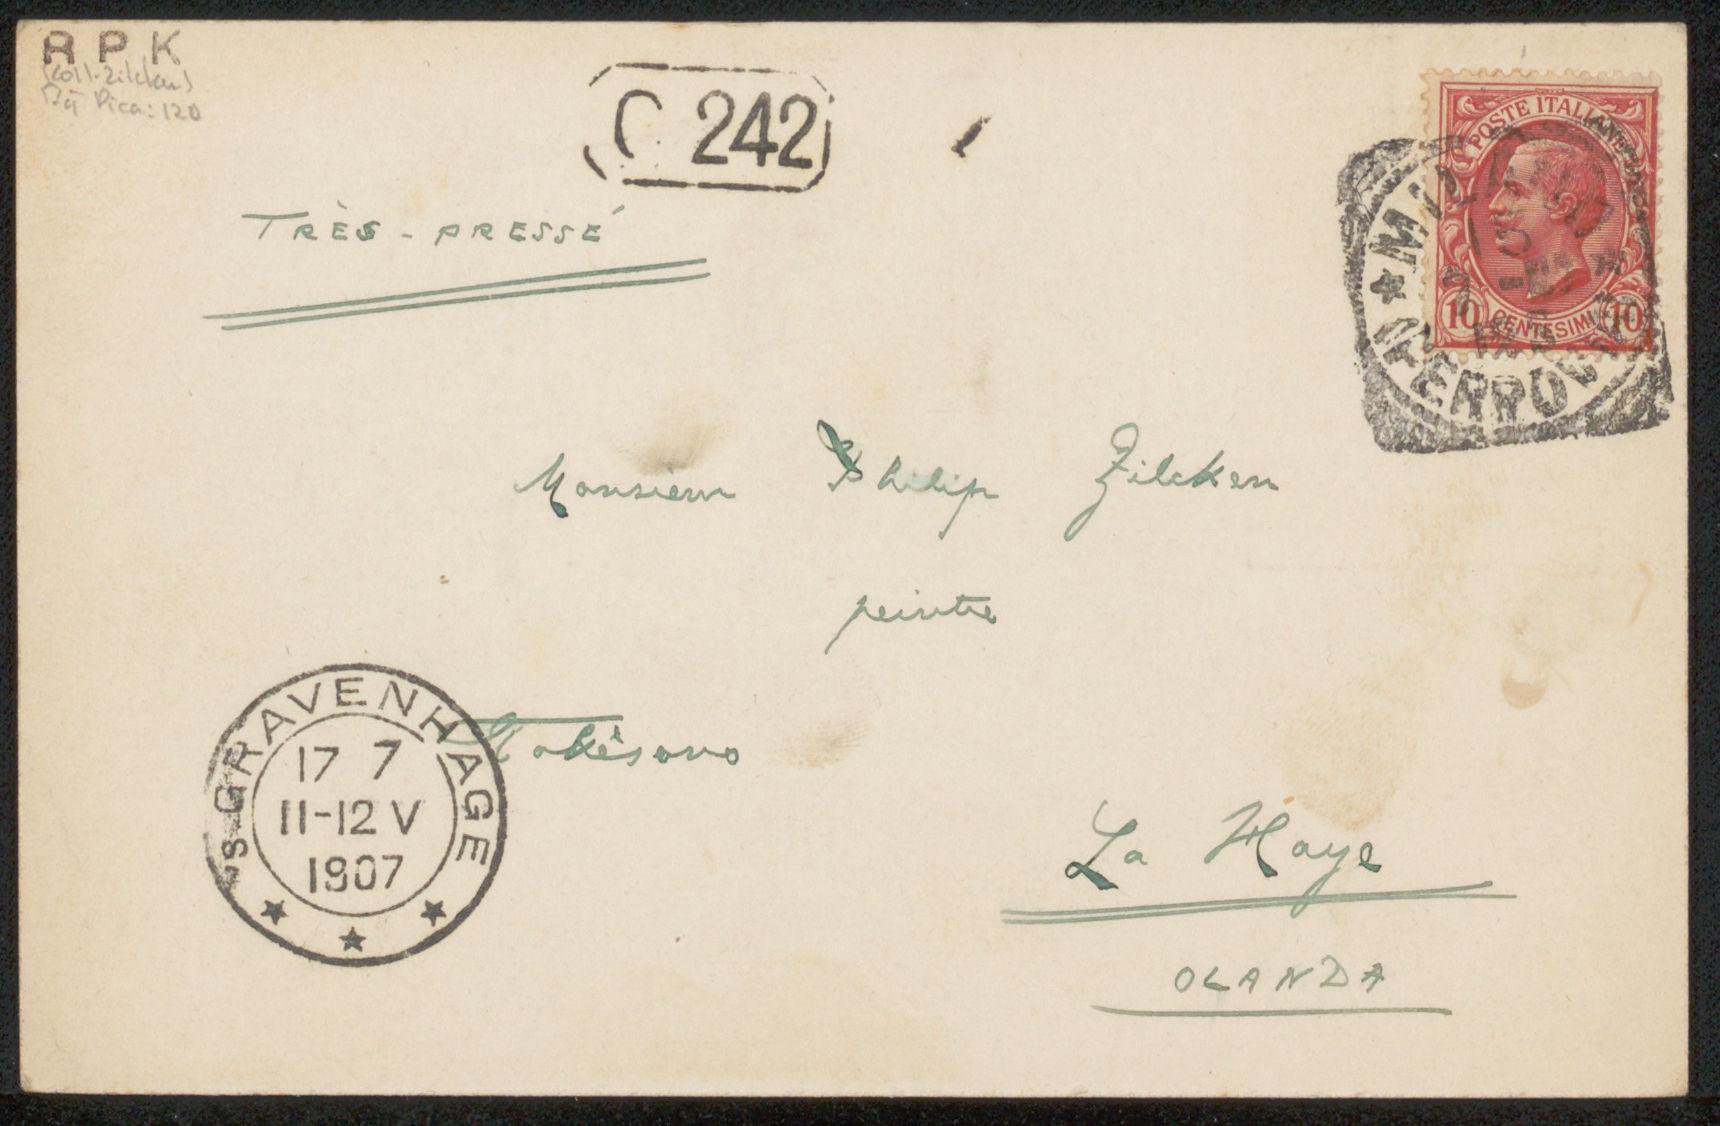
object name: letter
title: Brief aan Philip Zilcken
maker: vittorio pica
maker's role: criticus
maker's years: 1864-1930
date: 1907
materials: cardboard, ink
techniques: pen, printing, writing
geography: milan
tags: the hague, painter, draughtsman, sientje mesdag-van houten, suze robertson, amsterdam, gerard muller, philip zilcken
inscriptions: collector's mark: ‘RPK’